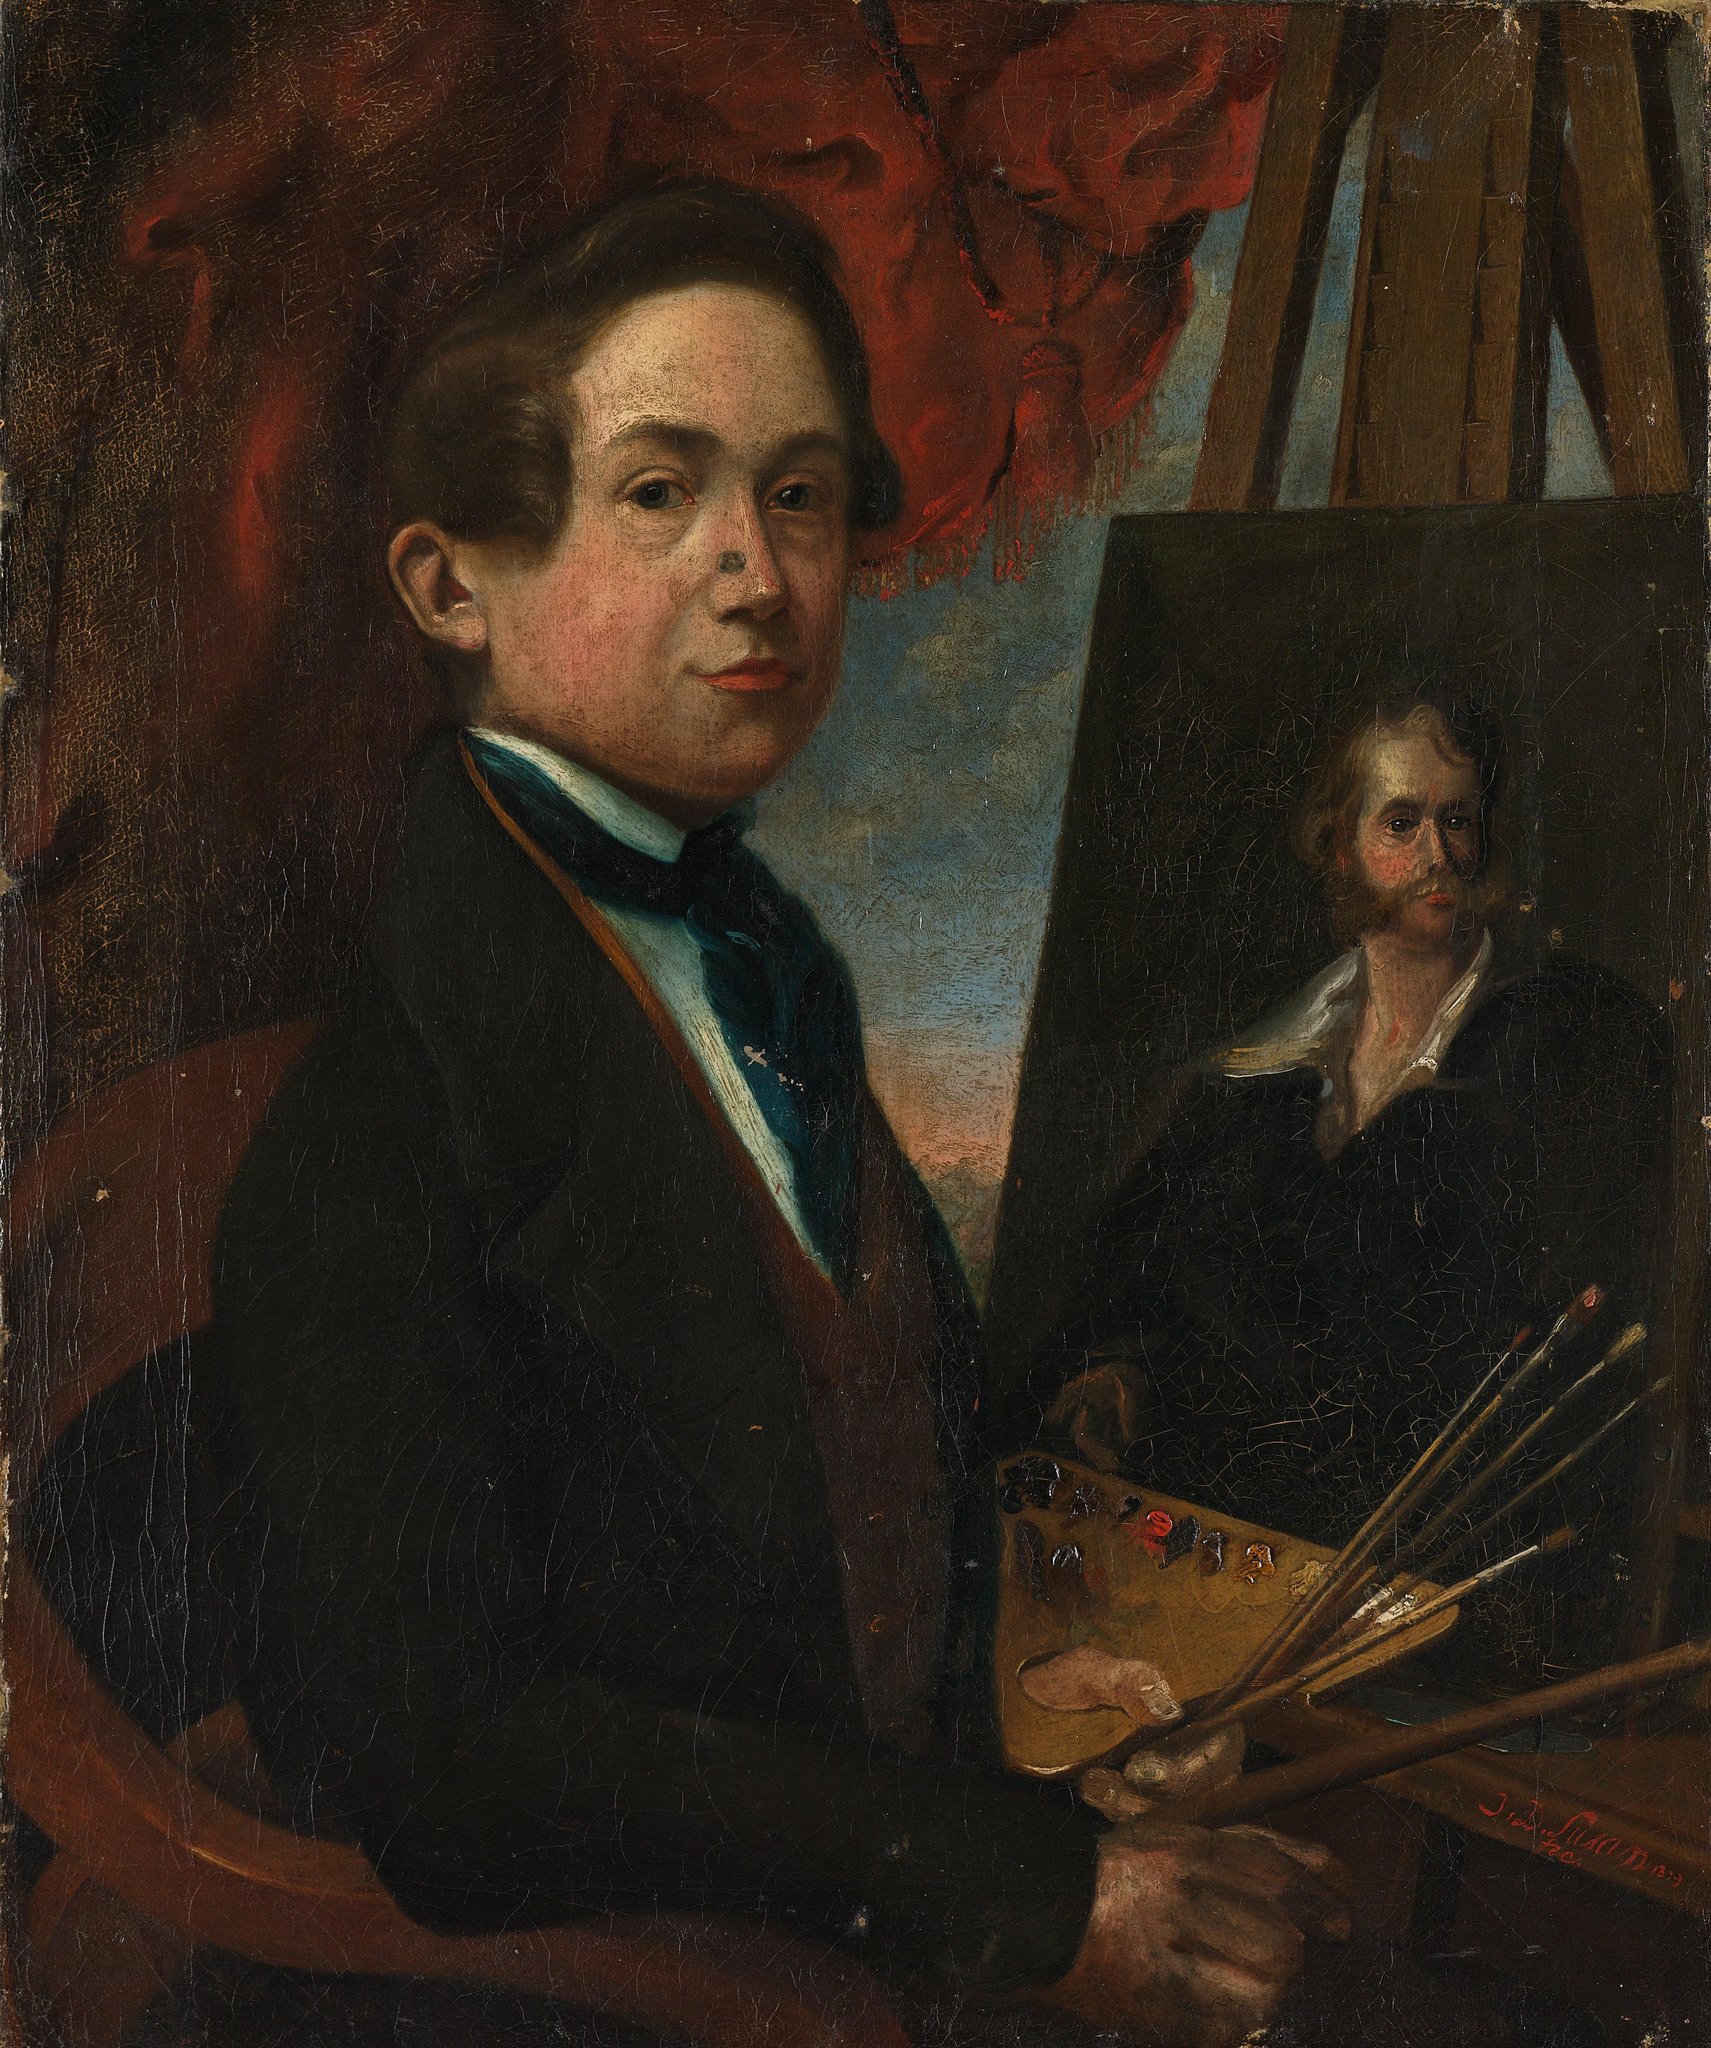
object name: painting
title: Self Portrait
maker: johannes daniël susan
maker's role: painter, print maker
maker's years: 1823-1843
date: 1839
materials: canvas, oil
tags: the hague, painter, print maker, johannes daniël susan, portrait, self-portrait of painter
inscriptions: signature and date: ‘J.D. Susan 1839 fec.’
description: Zelfportret van de schilder Johannes Daniël Susan. Ten halven lijve, zittend in een stoel voor een schilderij met een mansportret, palet en penselen in de linkerhand.